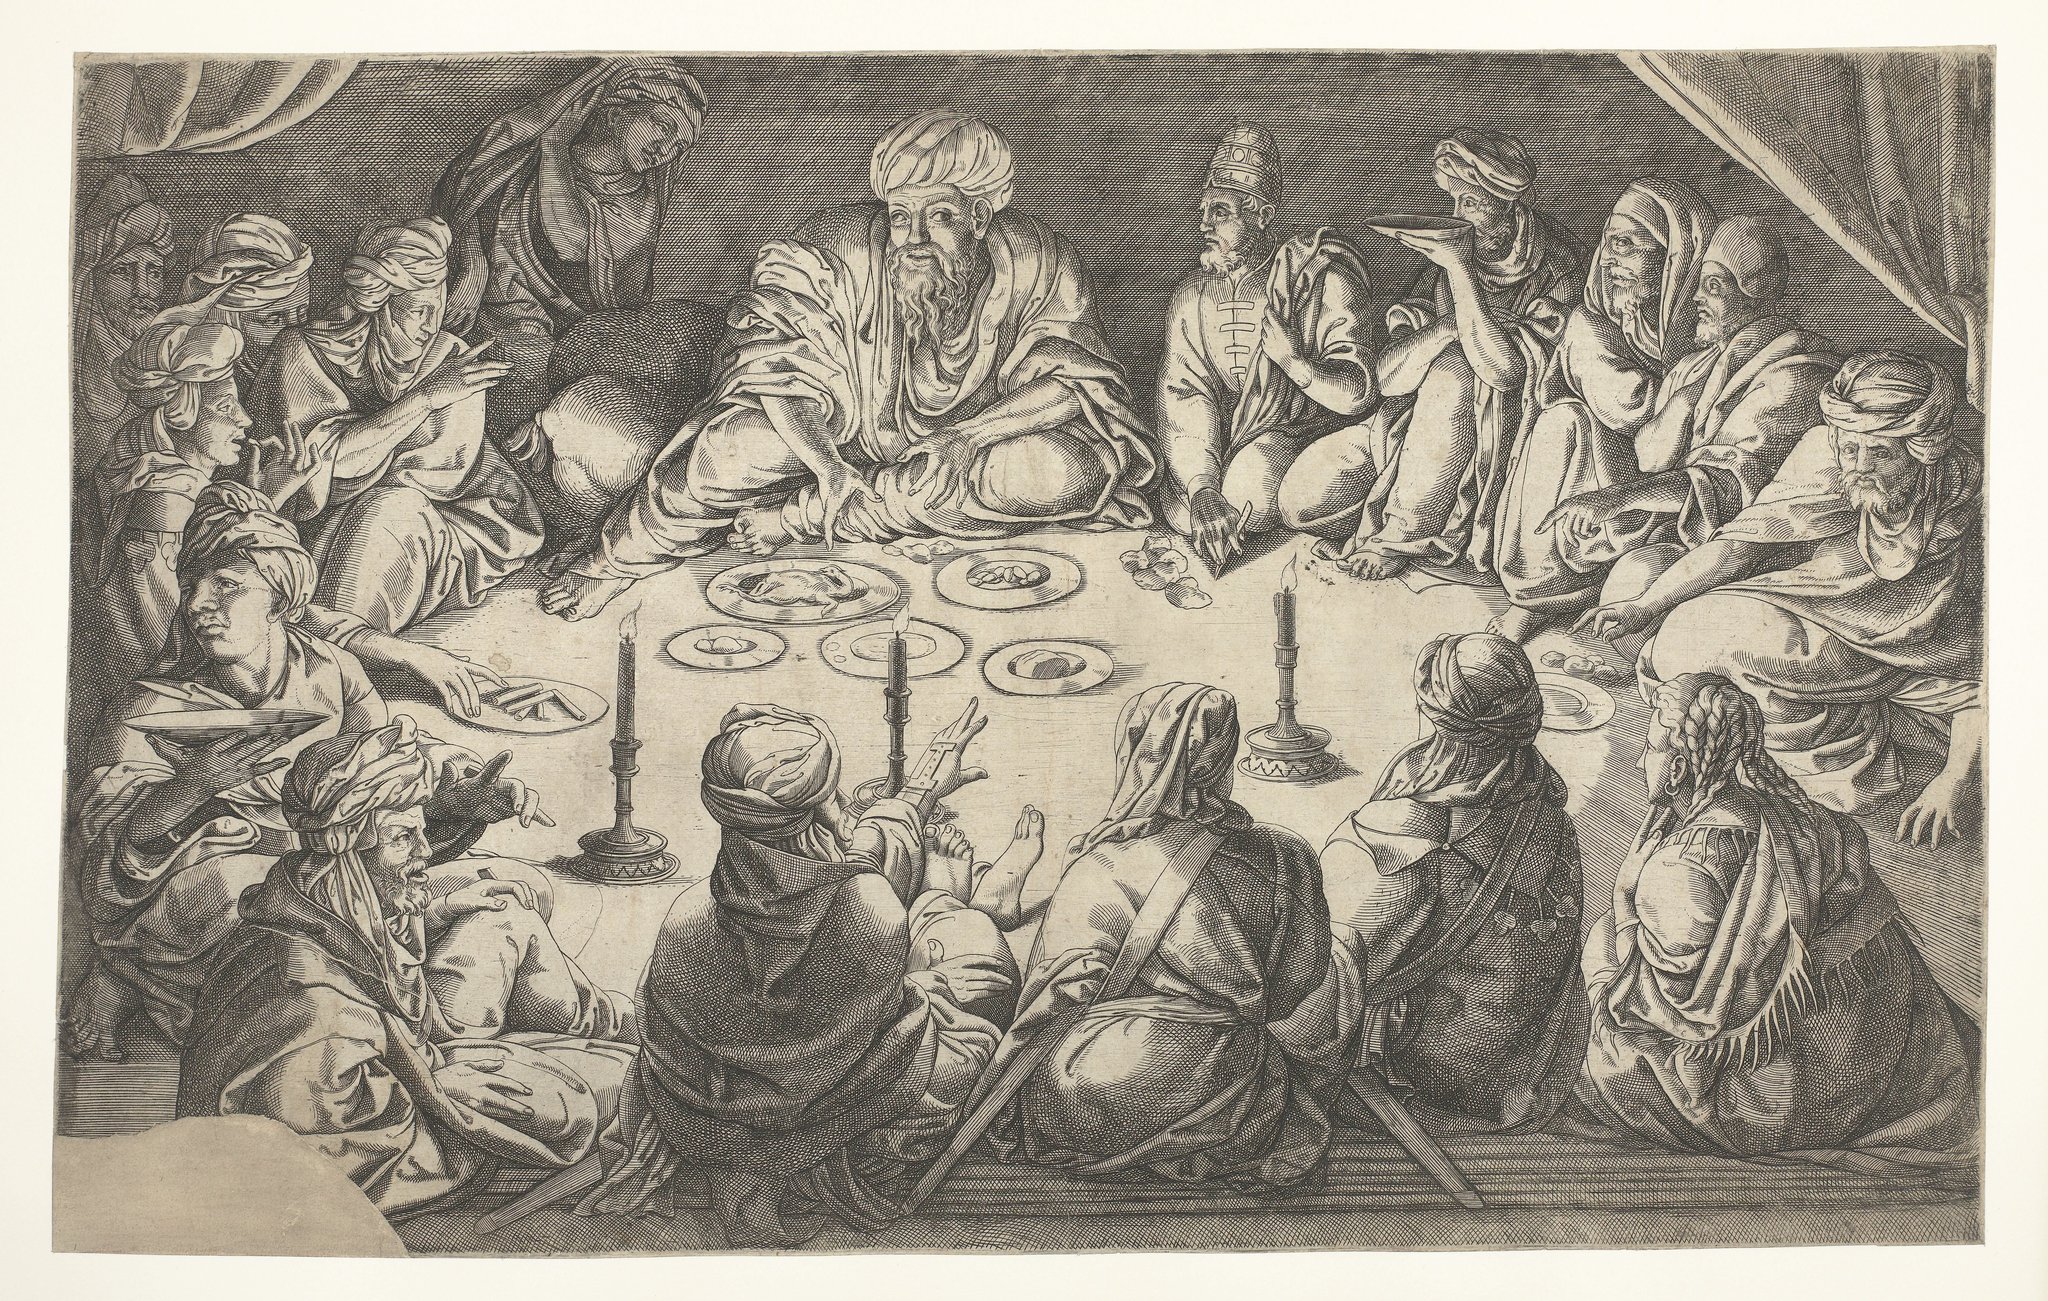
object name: print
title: Figures in North African Attire Seated around a Table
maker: jan cornelisz vermeyen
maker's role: draughtsman, painter, print maker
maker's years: 1500-1559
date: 1513-1559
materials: paper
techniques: etching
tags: asiatic races and peoples, celebration meal, feast, banquet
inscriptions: collector's mark: Lugt 2228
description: At the Conquest of Tunis in 1535 Emperor Charles V recaptured the city from the Turks. Vermeyen travelled with the troops and made sketches, which he worked out in prints upon his return. This scene is thought to represent Sultan Muley Hassan, who fought on the side of Charles v, and his entourage. Vermeyen’s interest in expressive gestures and powerful contrasts of light and dark is clearly visible in this print.